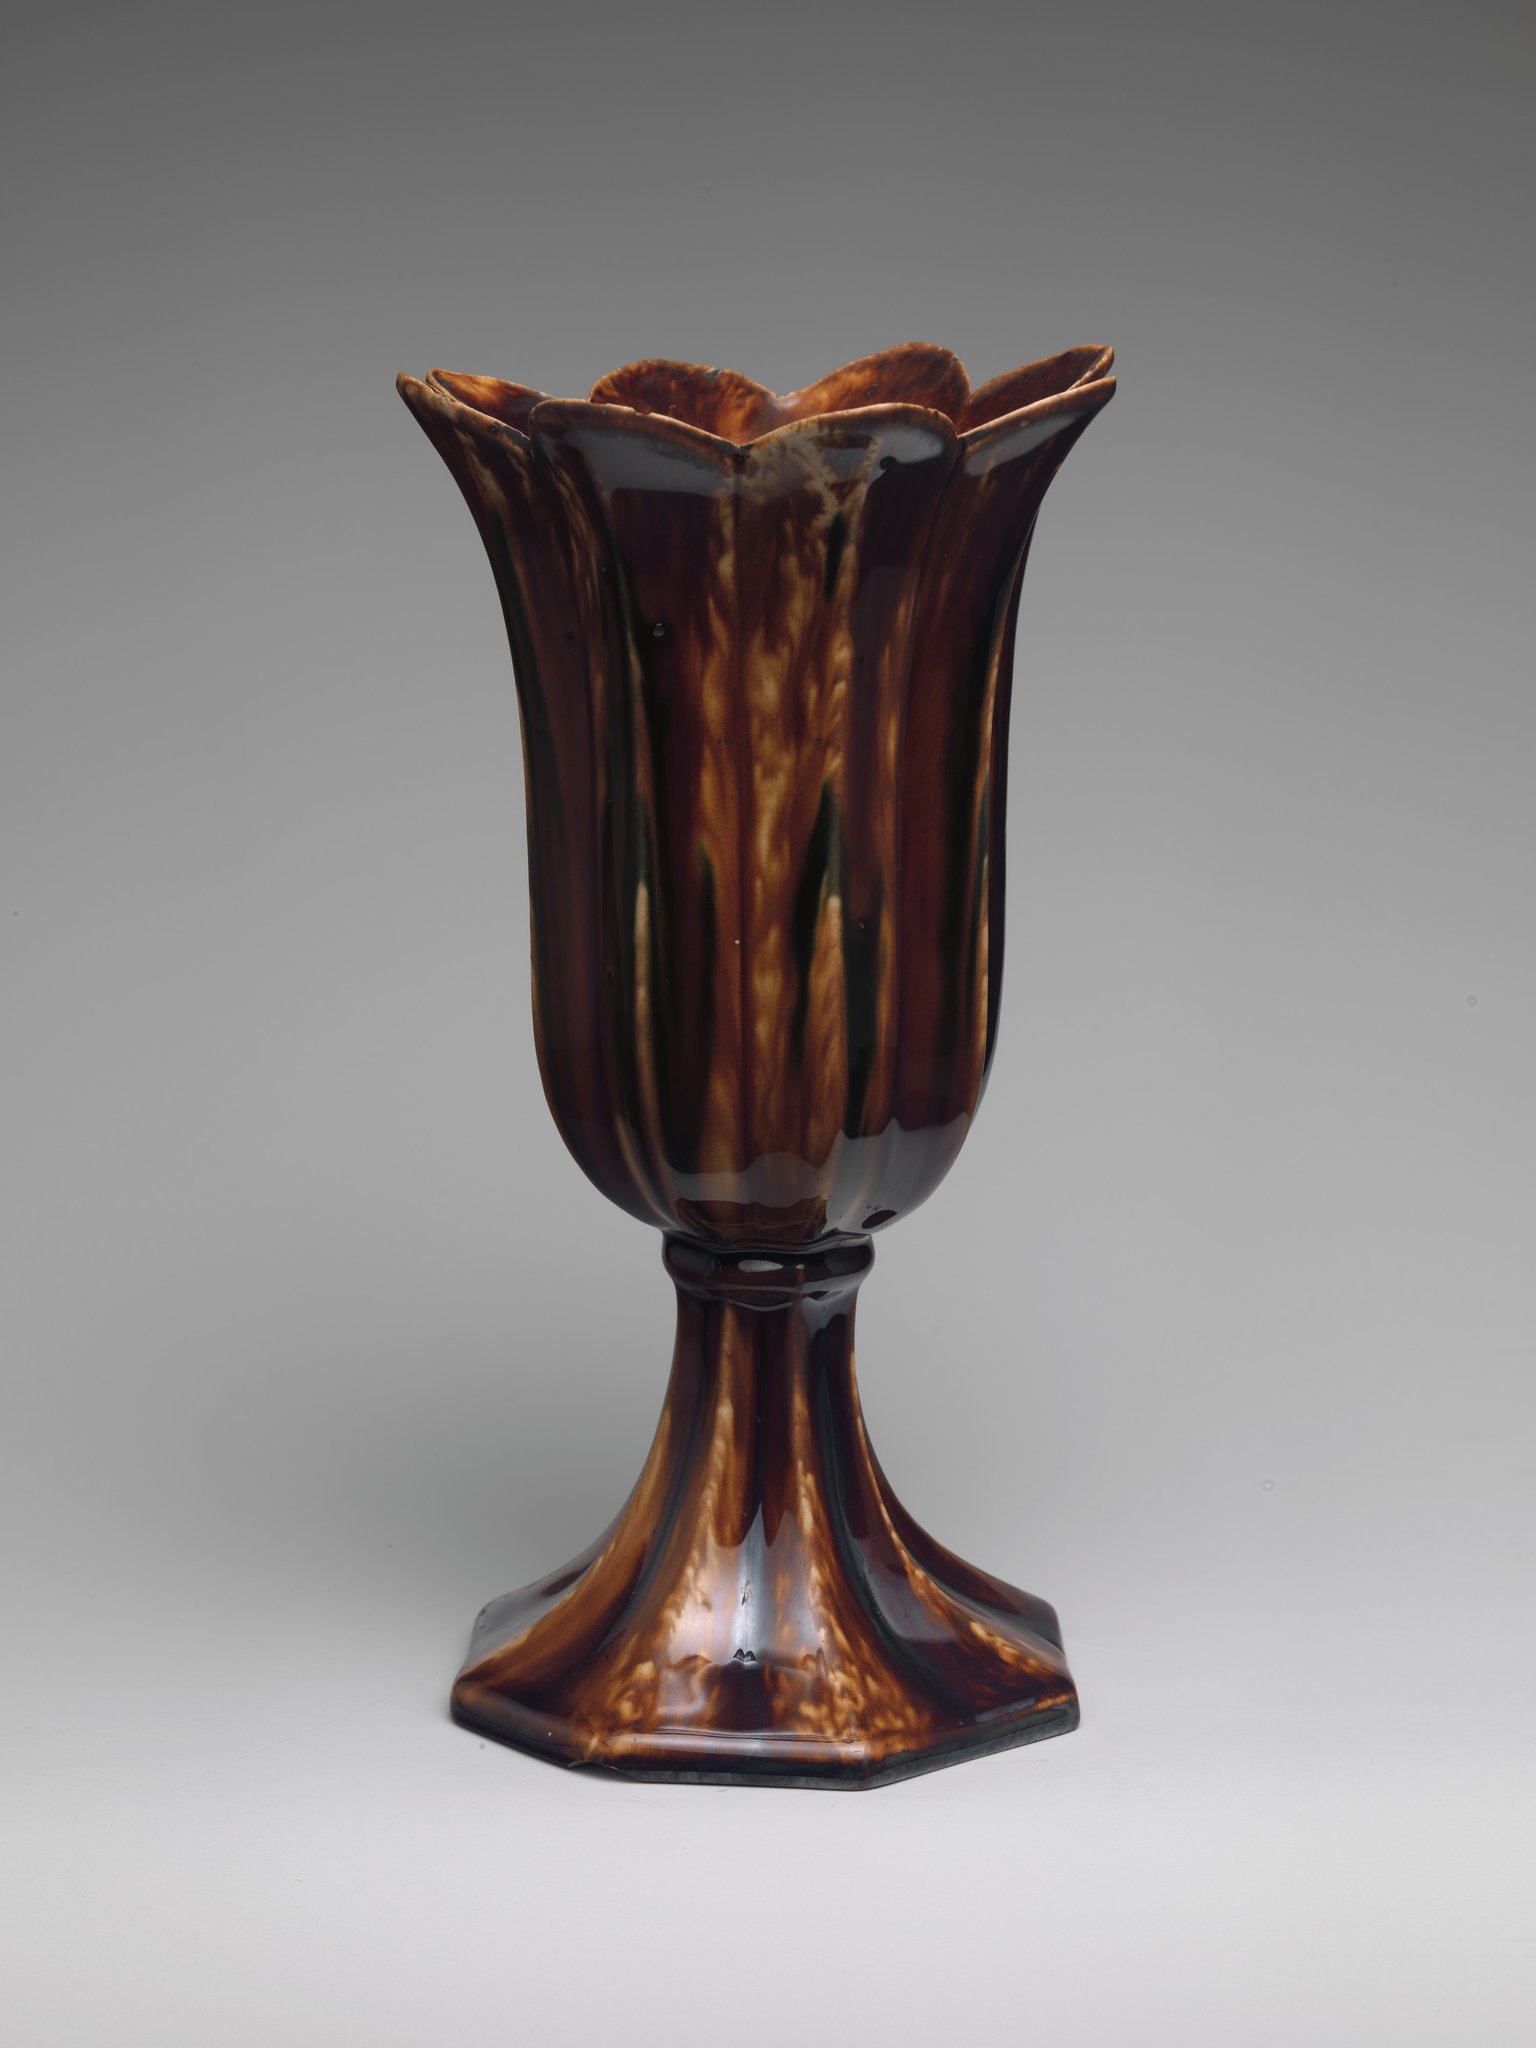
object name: celery dish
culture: american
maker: lyman, fenton & co.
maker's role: maker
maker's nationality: american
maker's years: 1849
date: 1849-1858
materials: earthenware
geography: united states